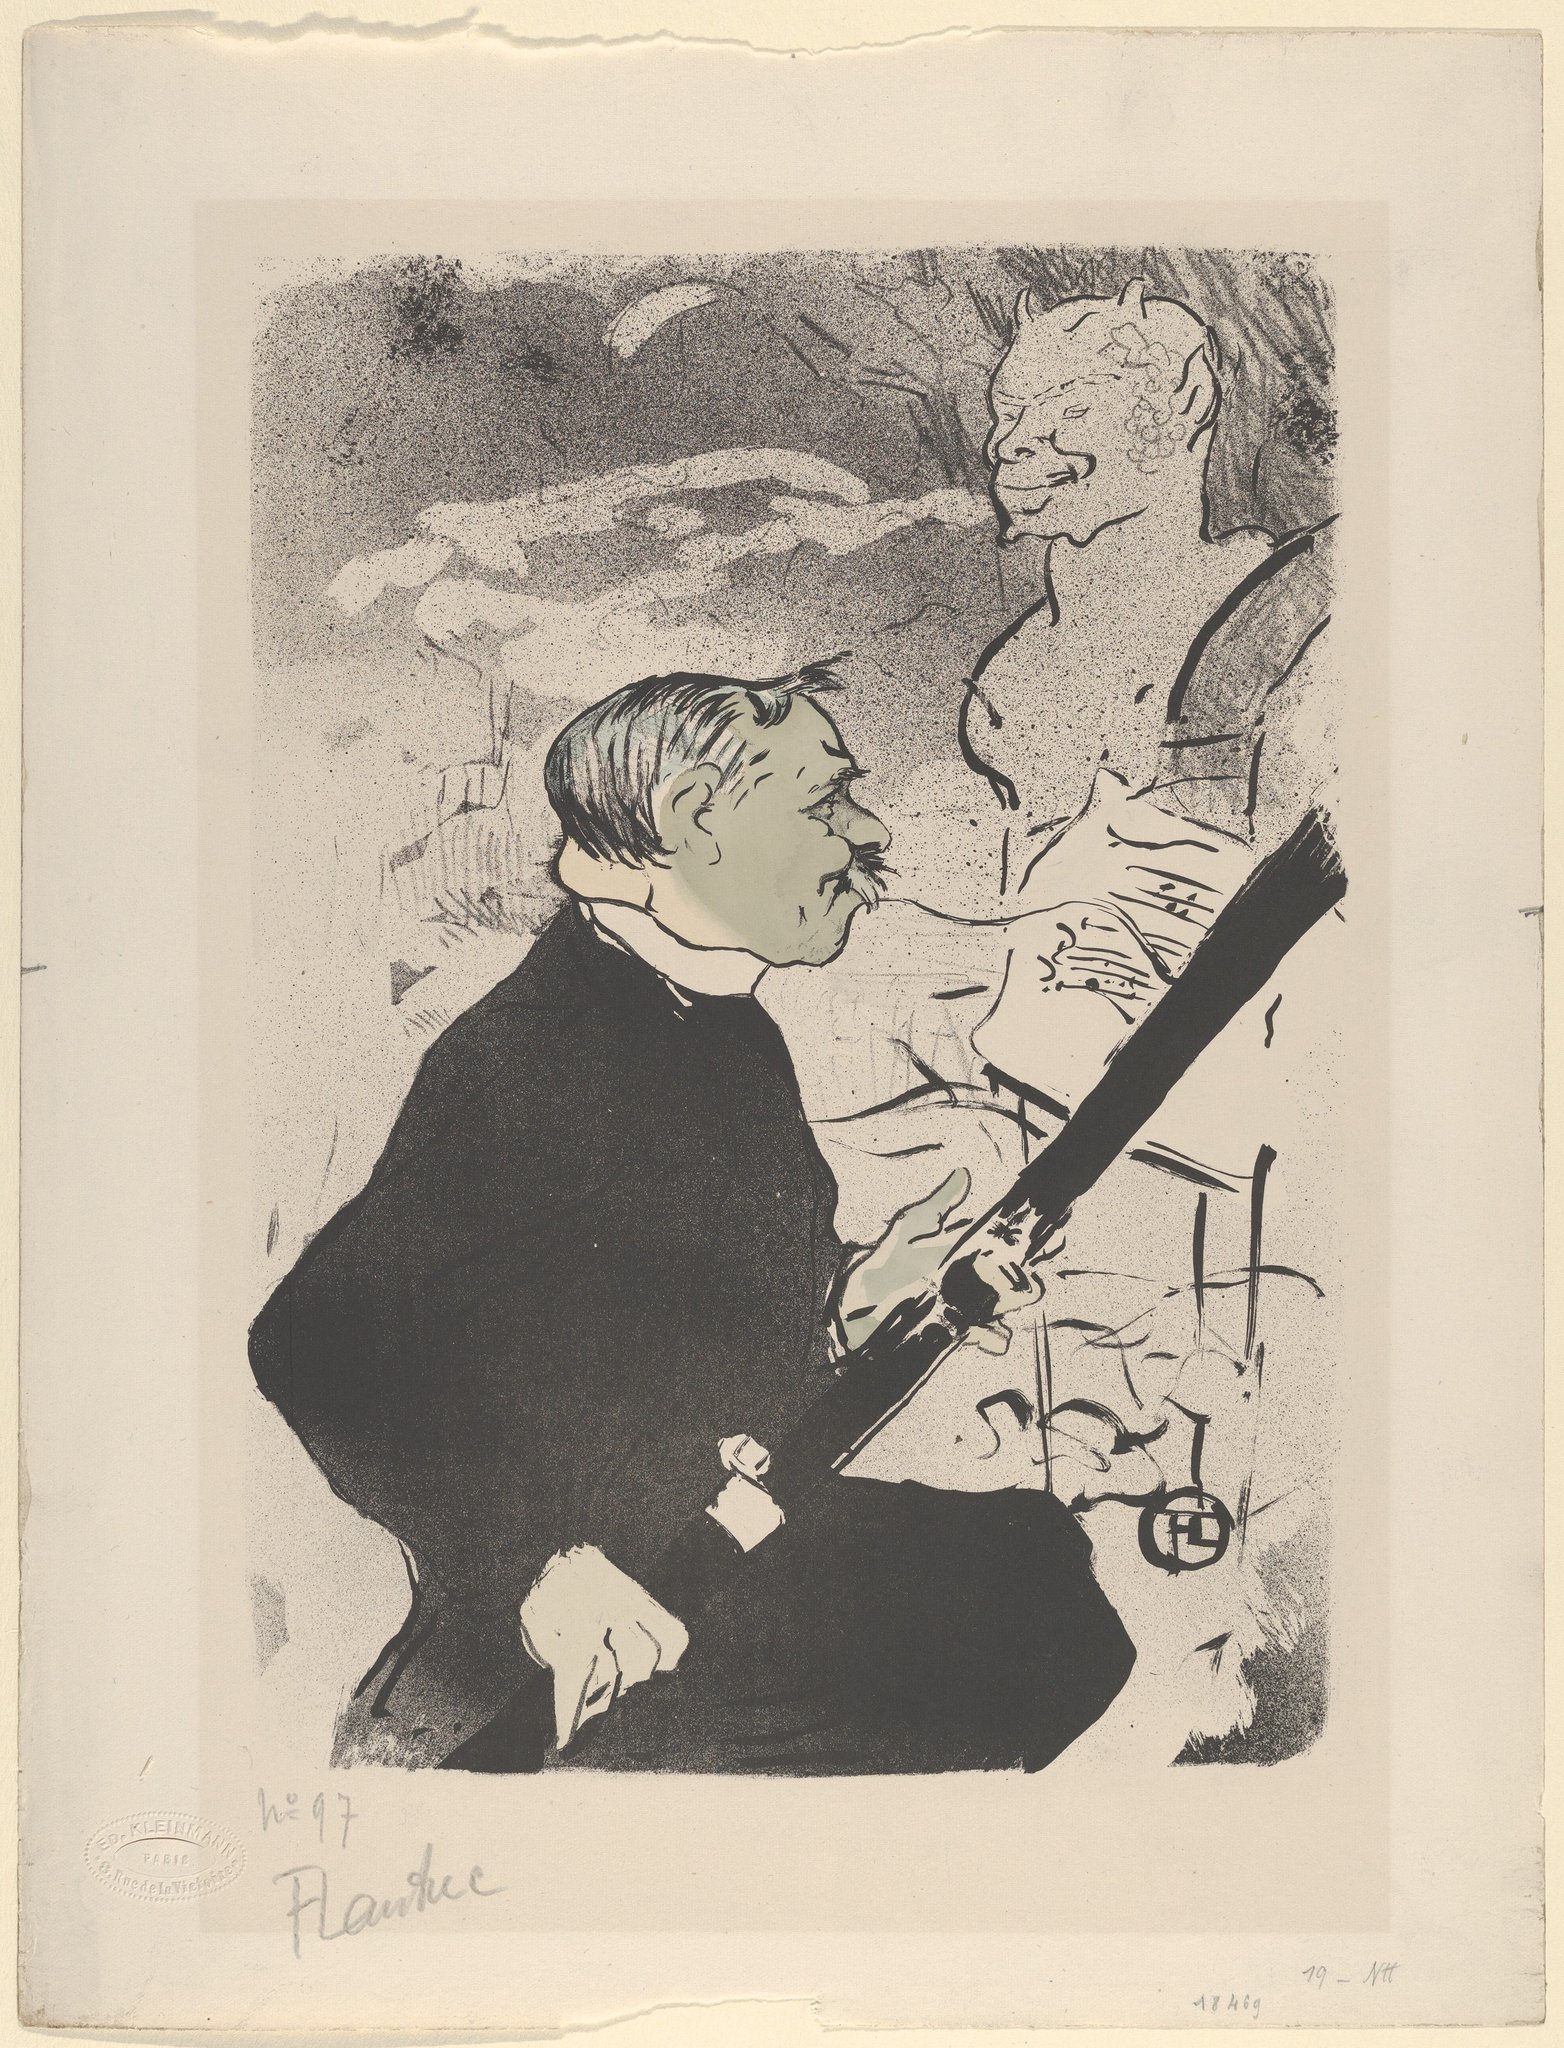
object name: print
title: For You!…, from "The Old Tales"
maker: henri de toulouse-lautrec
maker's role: artist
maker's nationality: french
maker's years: 1864-1901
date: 1893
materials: paper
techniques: coloring, lithograph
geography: france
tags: men